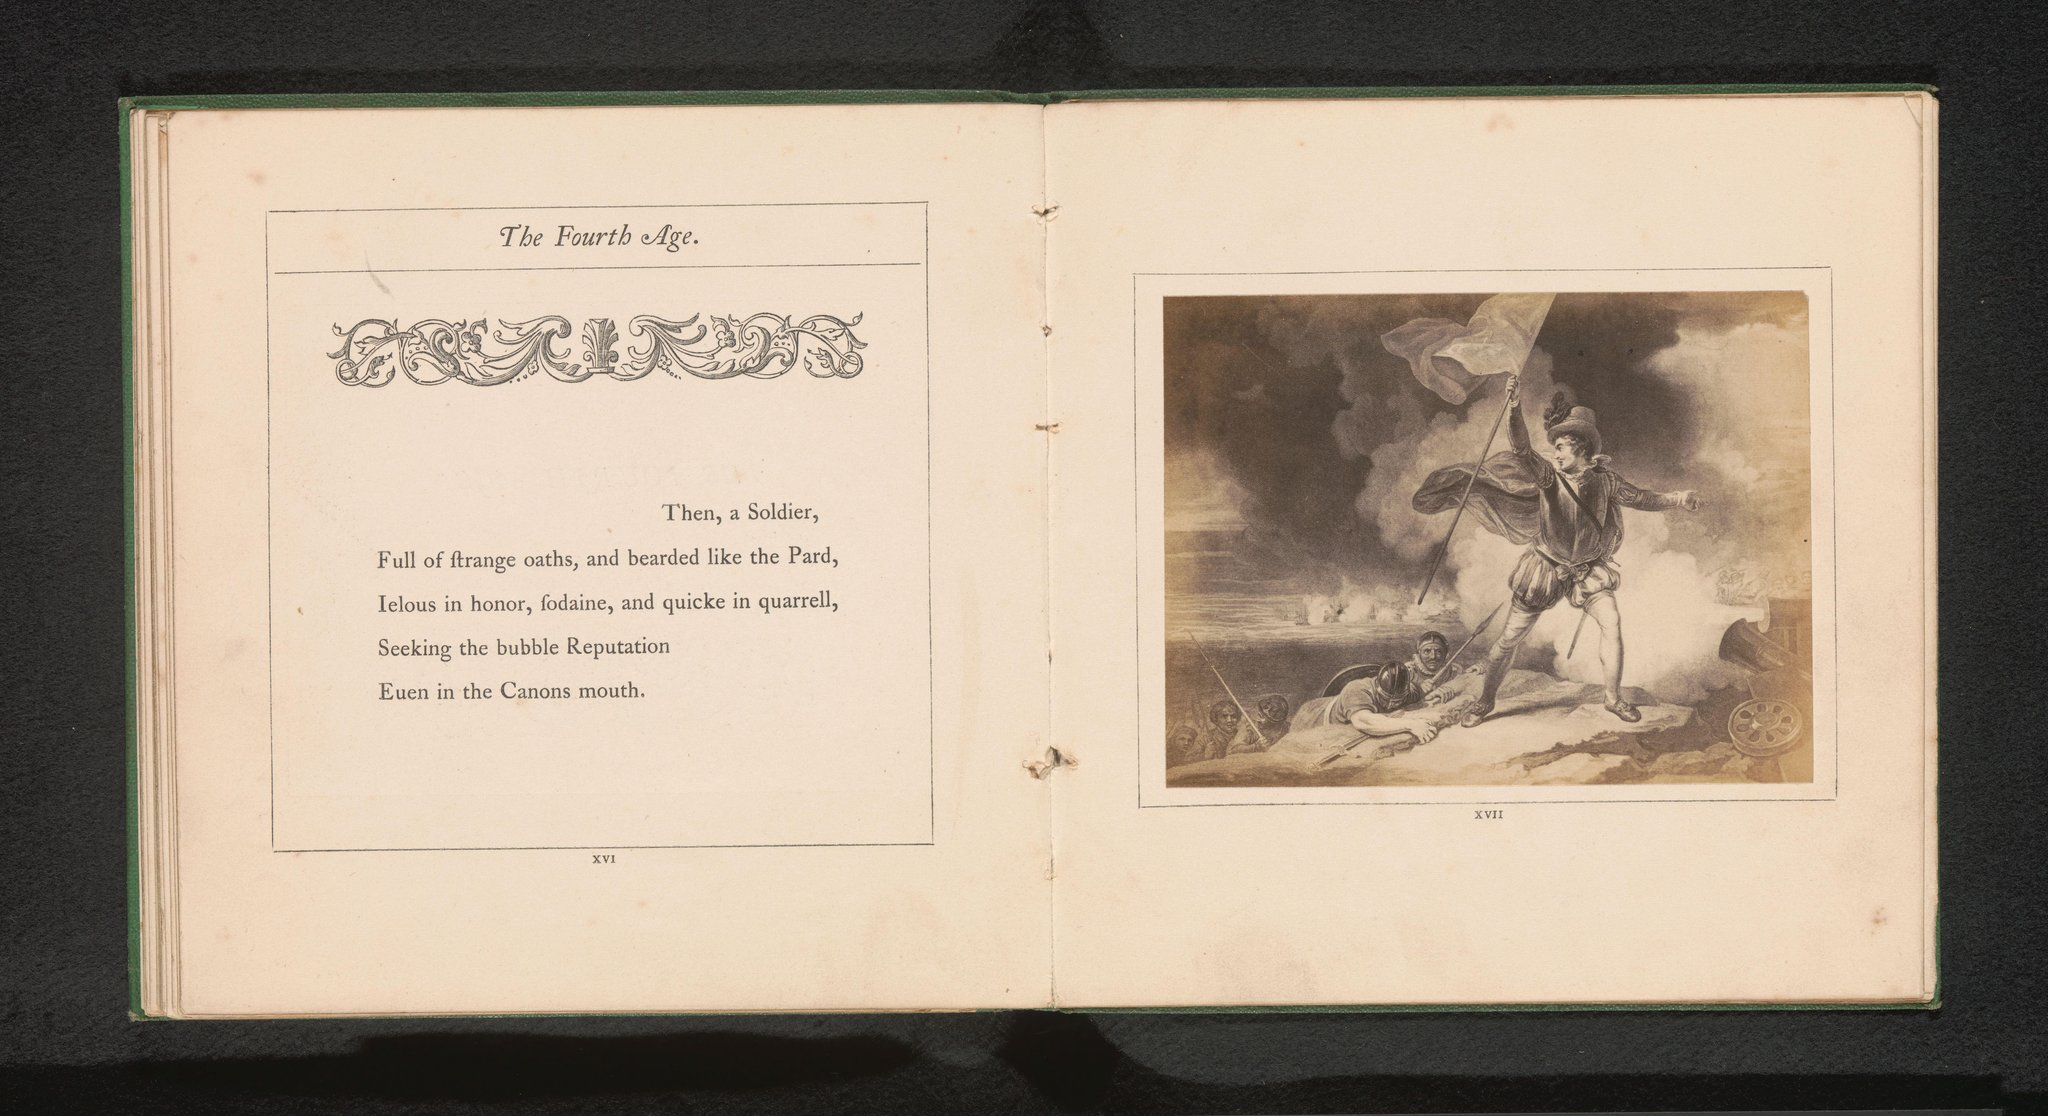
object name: page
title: Fotoreproductie van een prent, voorstellende een soldaat met een vlag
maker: stephen ayling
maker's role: fotograaf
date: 1854-1864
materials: photographic support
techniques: albumen print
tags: private soldier, (military) flags and standards